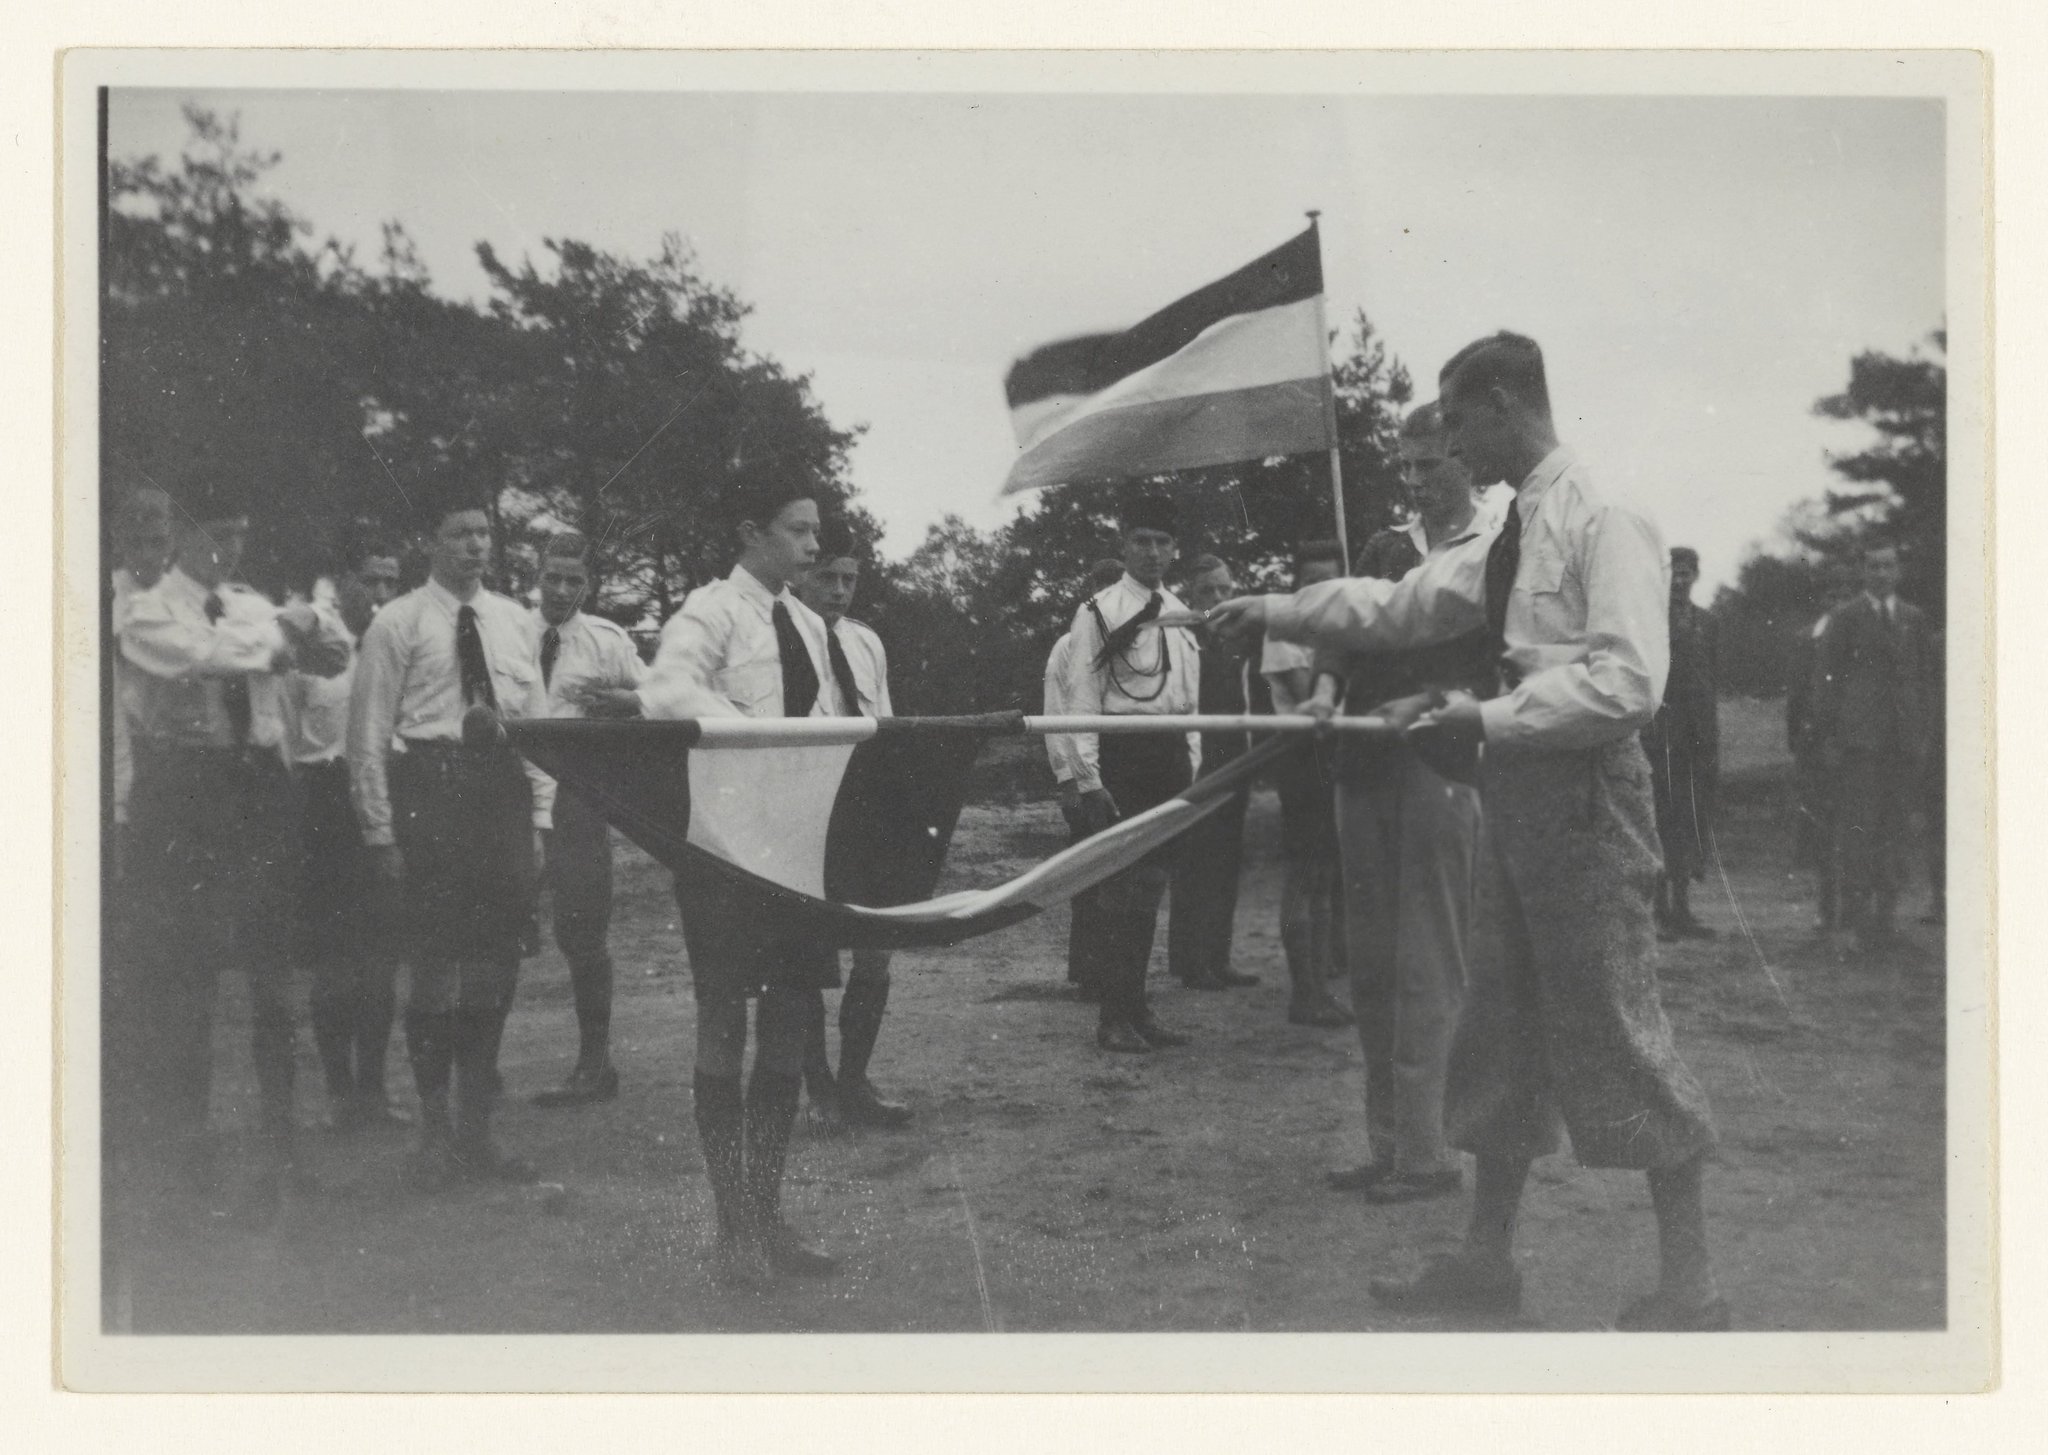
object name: photograph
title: Jeugdstorm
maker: Anonymous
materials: photographic support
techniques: gelatin silver print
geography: bilthoven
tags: belgium, official, military instruction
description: Jongens van de Jeugdstorm leggen een gelofte af op de Jeugdstorm tijdens hun installatie als lid. De leider Van Geelkerken houdt de vlag van de Jeugdstorm vast. Een ander lid de Nederlandse vlag. Op achterzijde foto: Installatie van troep I. (Gelofte). De foto maakt deel uit van een serie van circa 35 amateurfoto's.